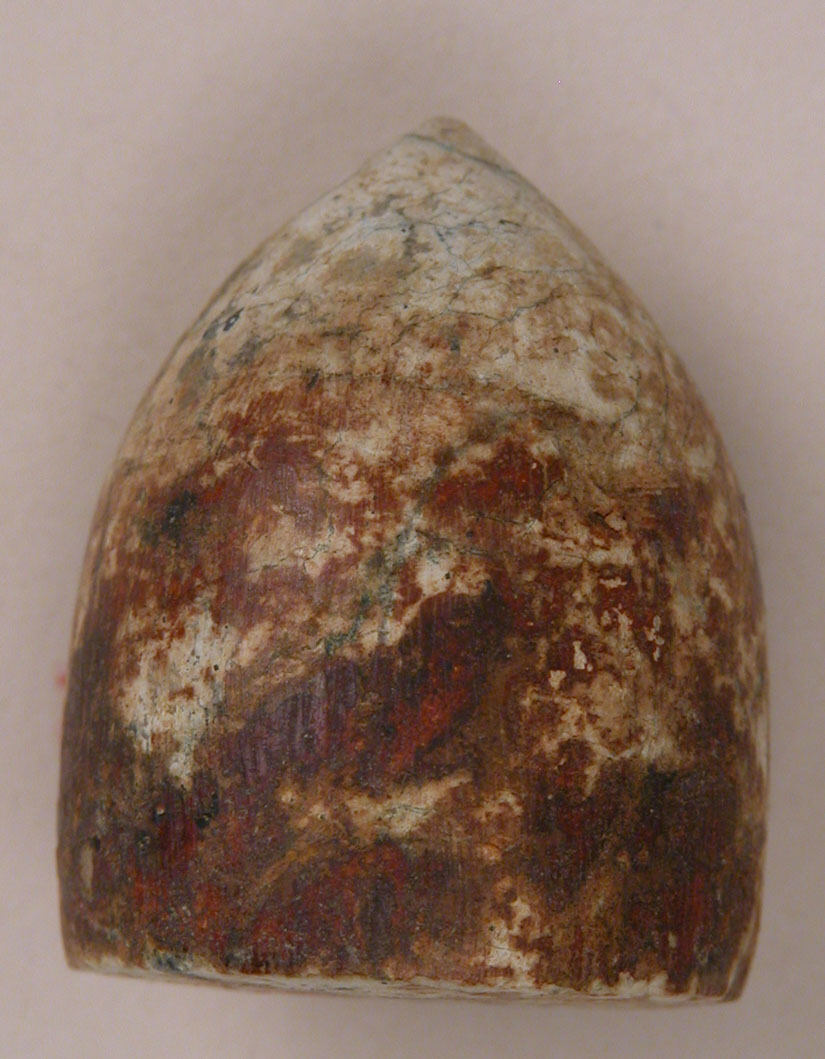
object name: gaming or chess piece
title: Gaming or Chess Piece, Possibly a Pawn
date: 701-1100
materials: stone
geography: western islamic lands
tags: chess